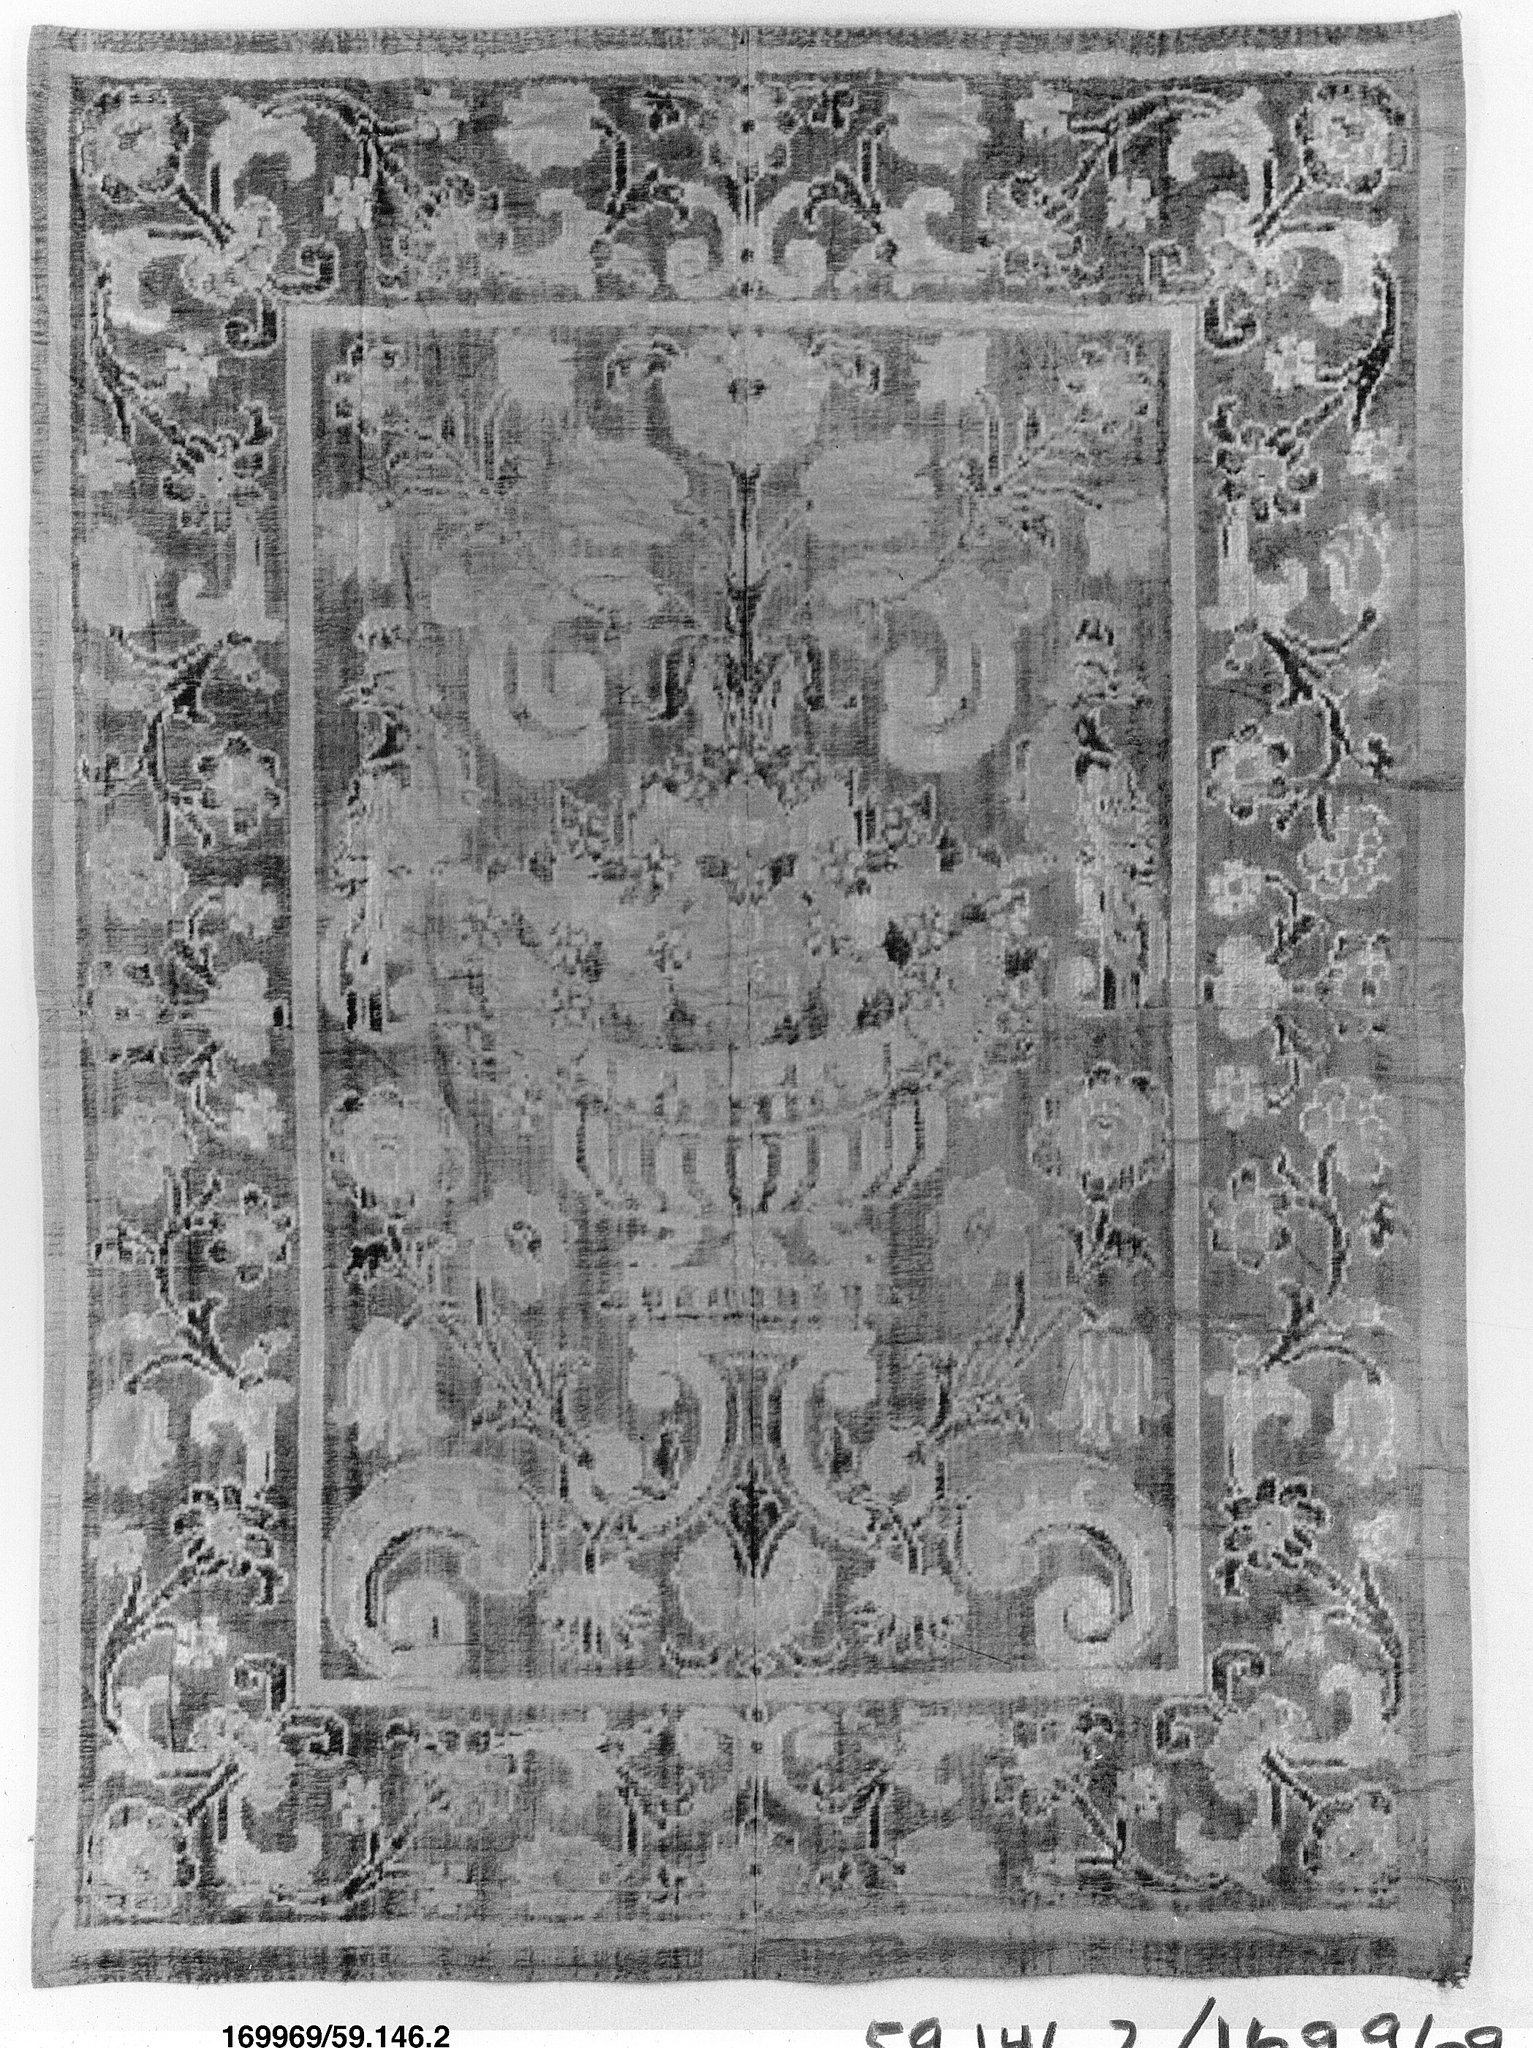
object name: hanging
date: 1601-1800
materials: cotton, silk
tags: flowers